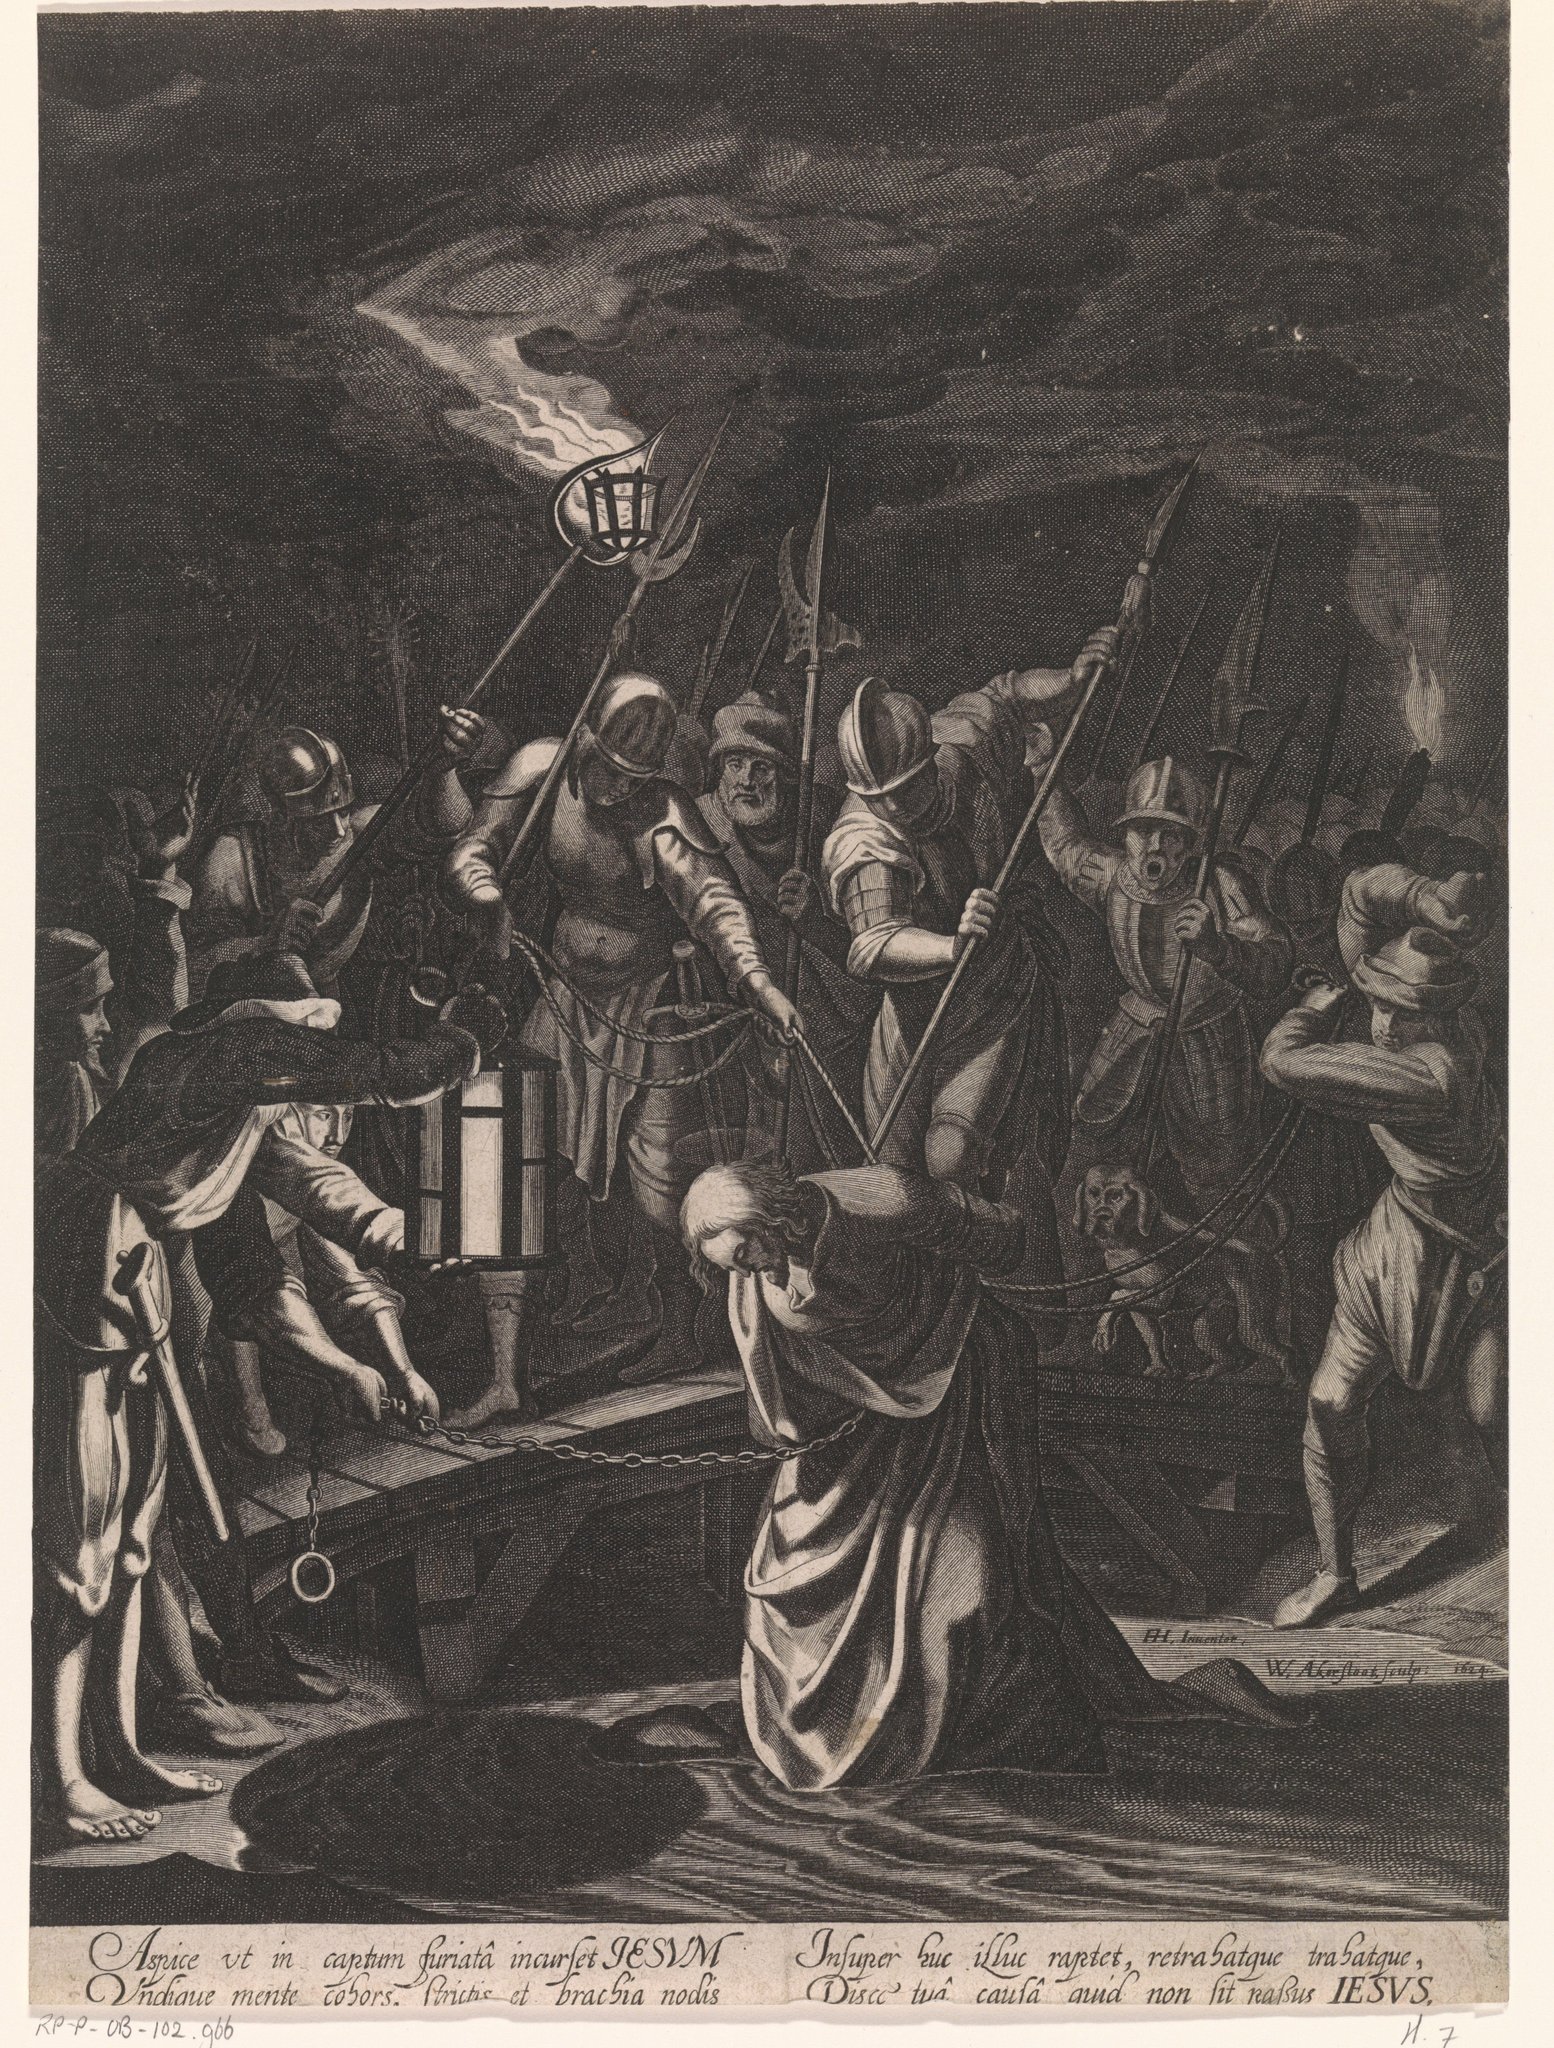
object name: print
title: Gevangenneming en wegvoering van Christus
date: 1624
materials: paper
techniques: engraving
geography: netherlands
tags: christ is dragged through the brook cedron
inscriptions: collector's mark: Lugt 2228, collector's mark: Lugt 240, collector's mark: Lugt 699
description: Christus, geketend met touwen en kettingen, wordt 's nachts door een groep soldaten door een beek gevoerd. Onder de voorstelling twee tweeregelige verzen in het Latijn.